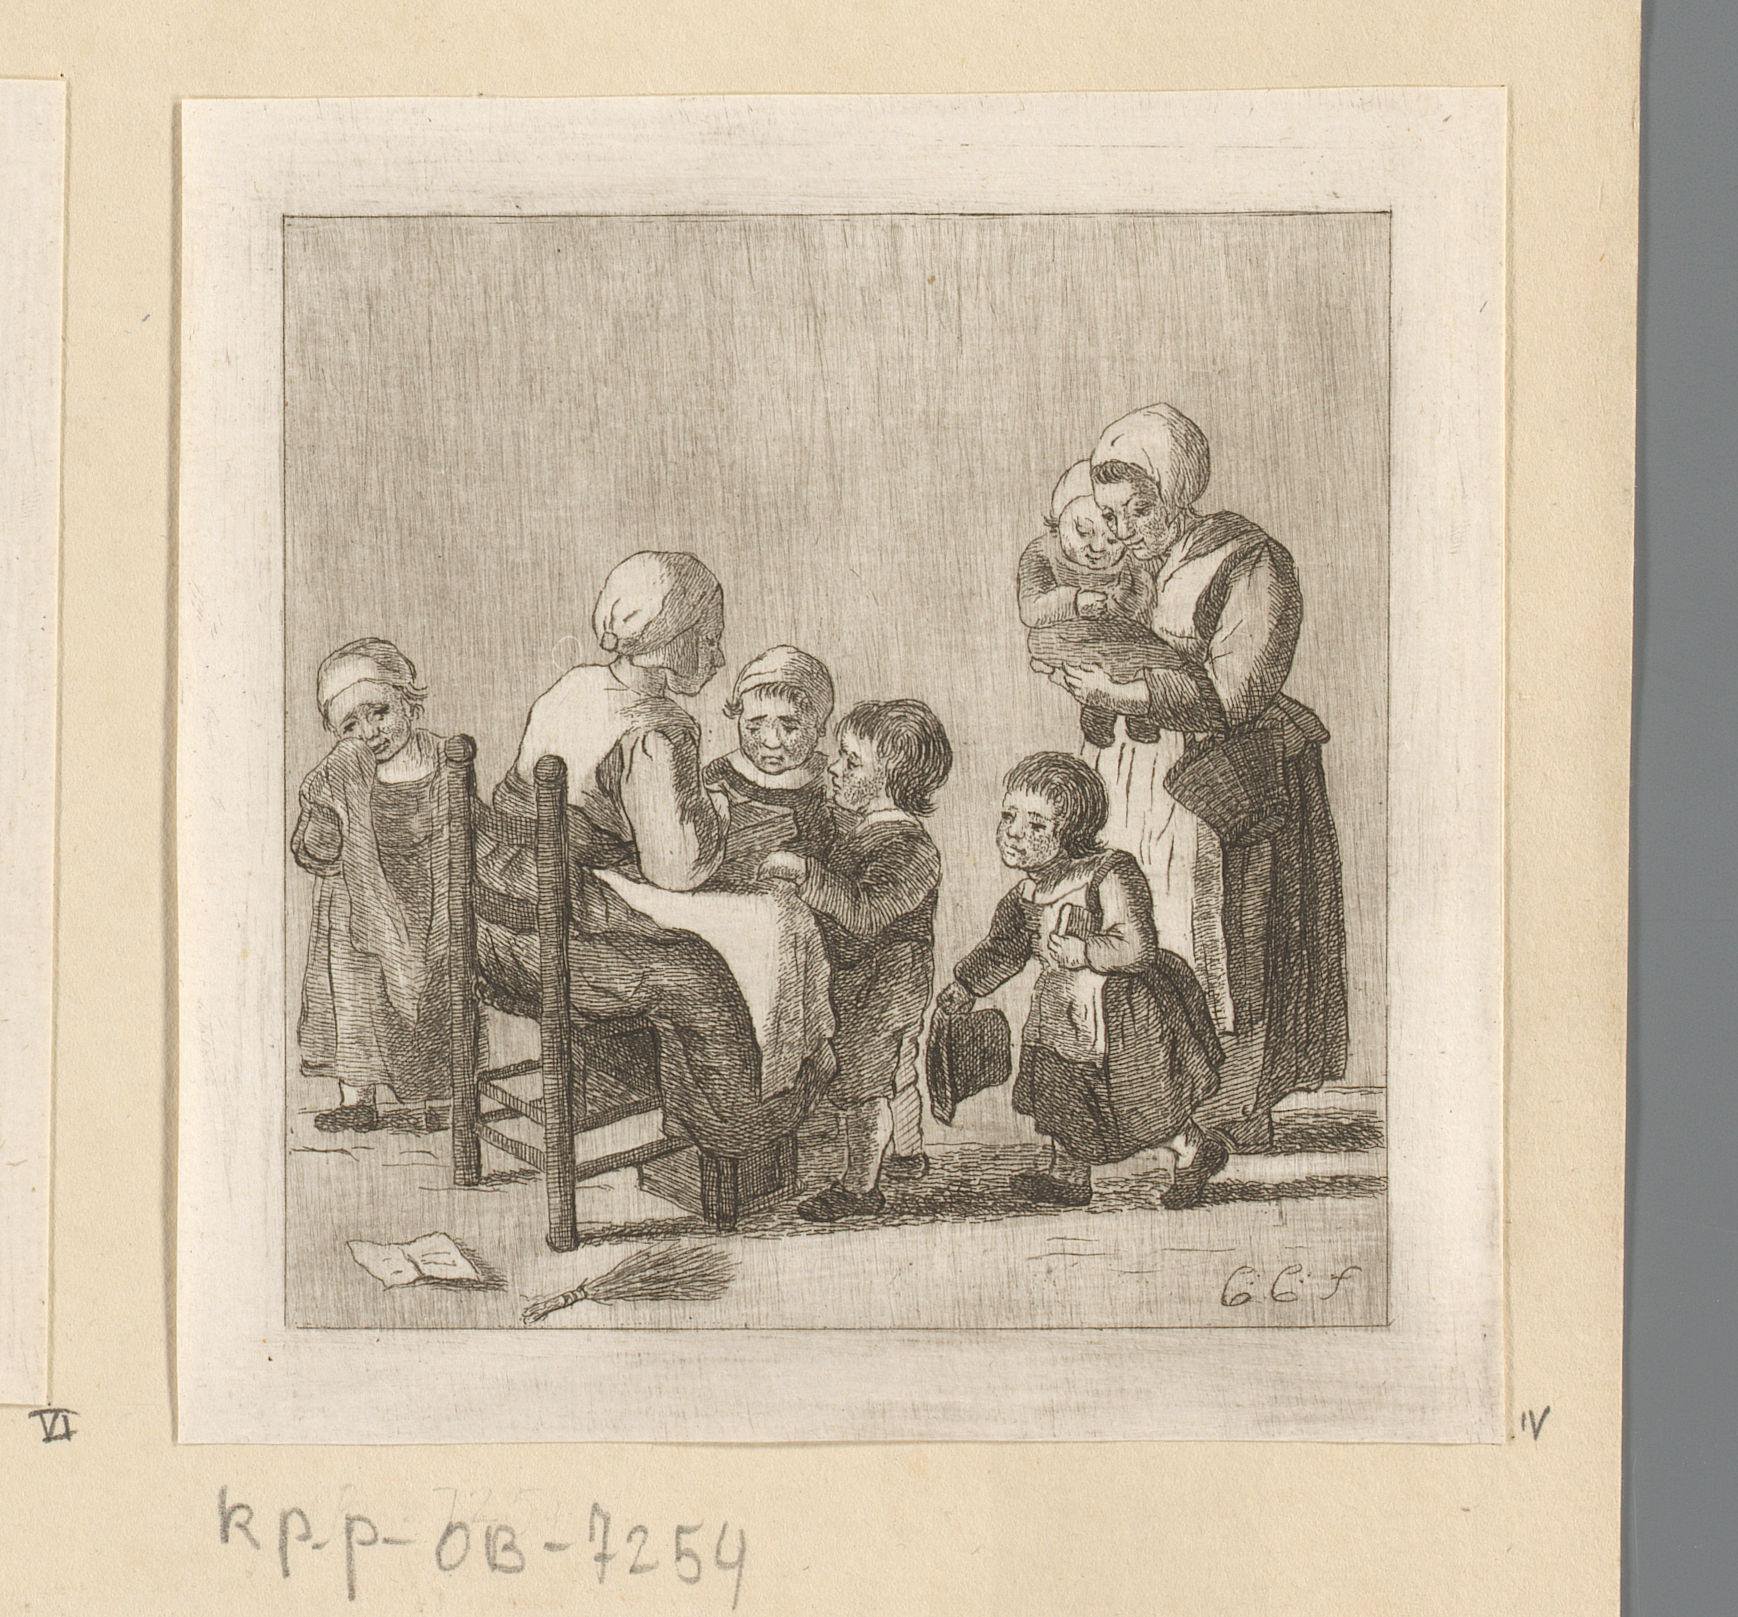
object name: print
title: Schoolklas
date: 1779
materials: paper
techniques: etching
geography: leiden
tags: teacher and pupil, rod, birch ~ punishment at school, nursery school, mischievous child (at school)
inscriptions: collector's mark: Lugt 2228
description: Een kinderschool. Een lerares zit op een stoel en leest kinderen de les uit een boek. Rechts komt een moeder haar dochter brengen. Links staat een meisje te huilen. Onder de stoel van de lerares ligt een roede.